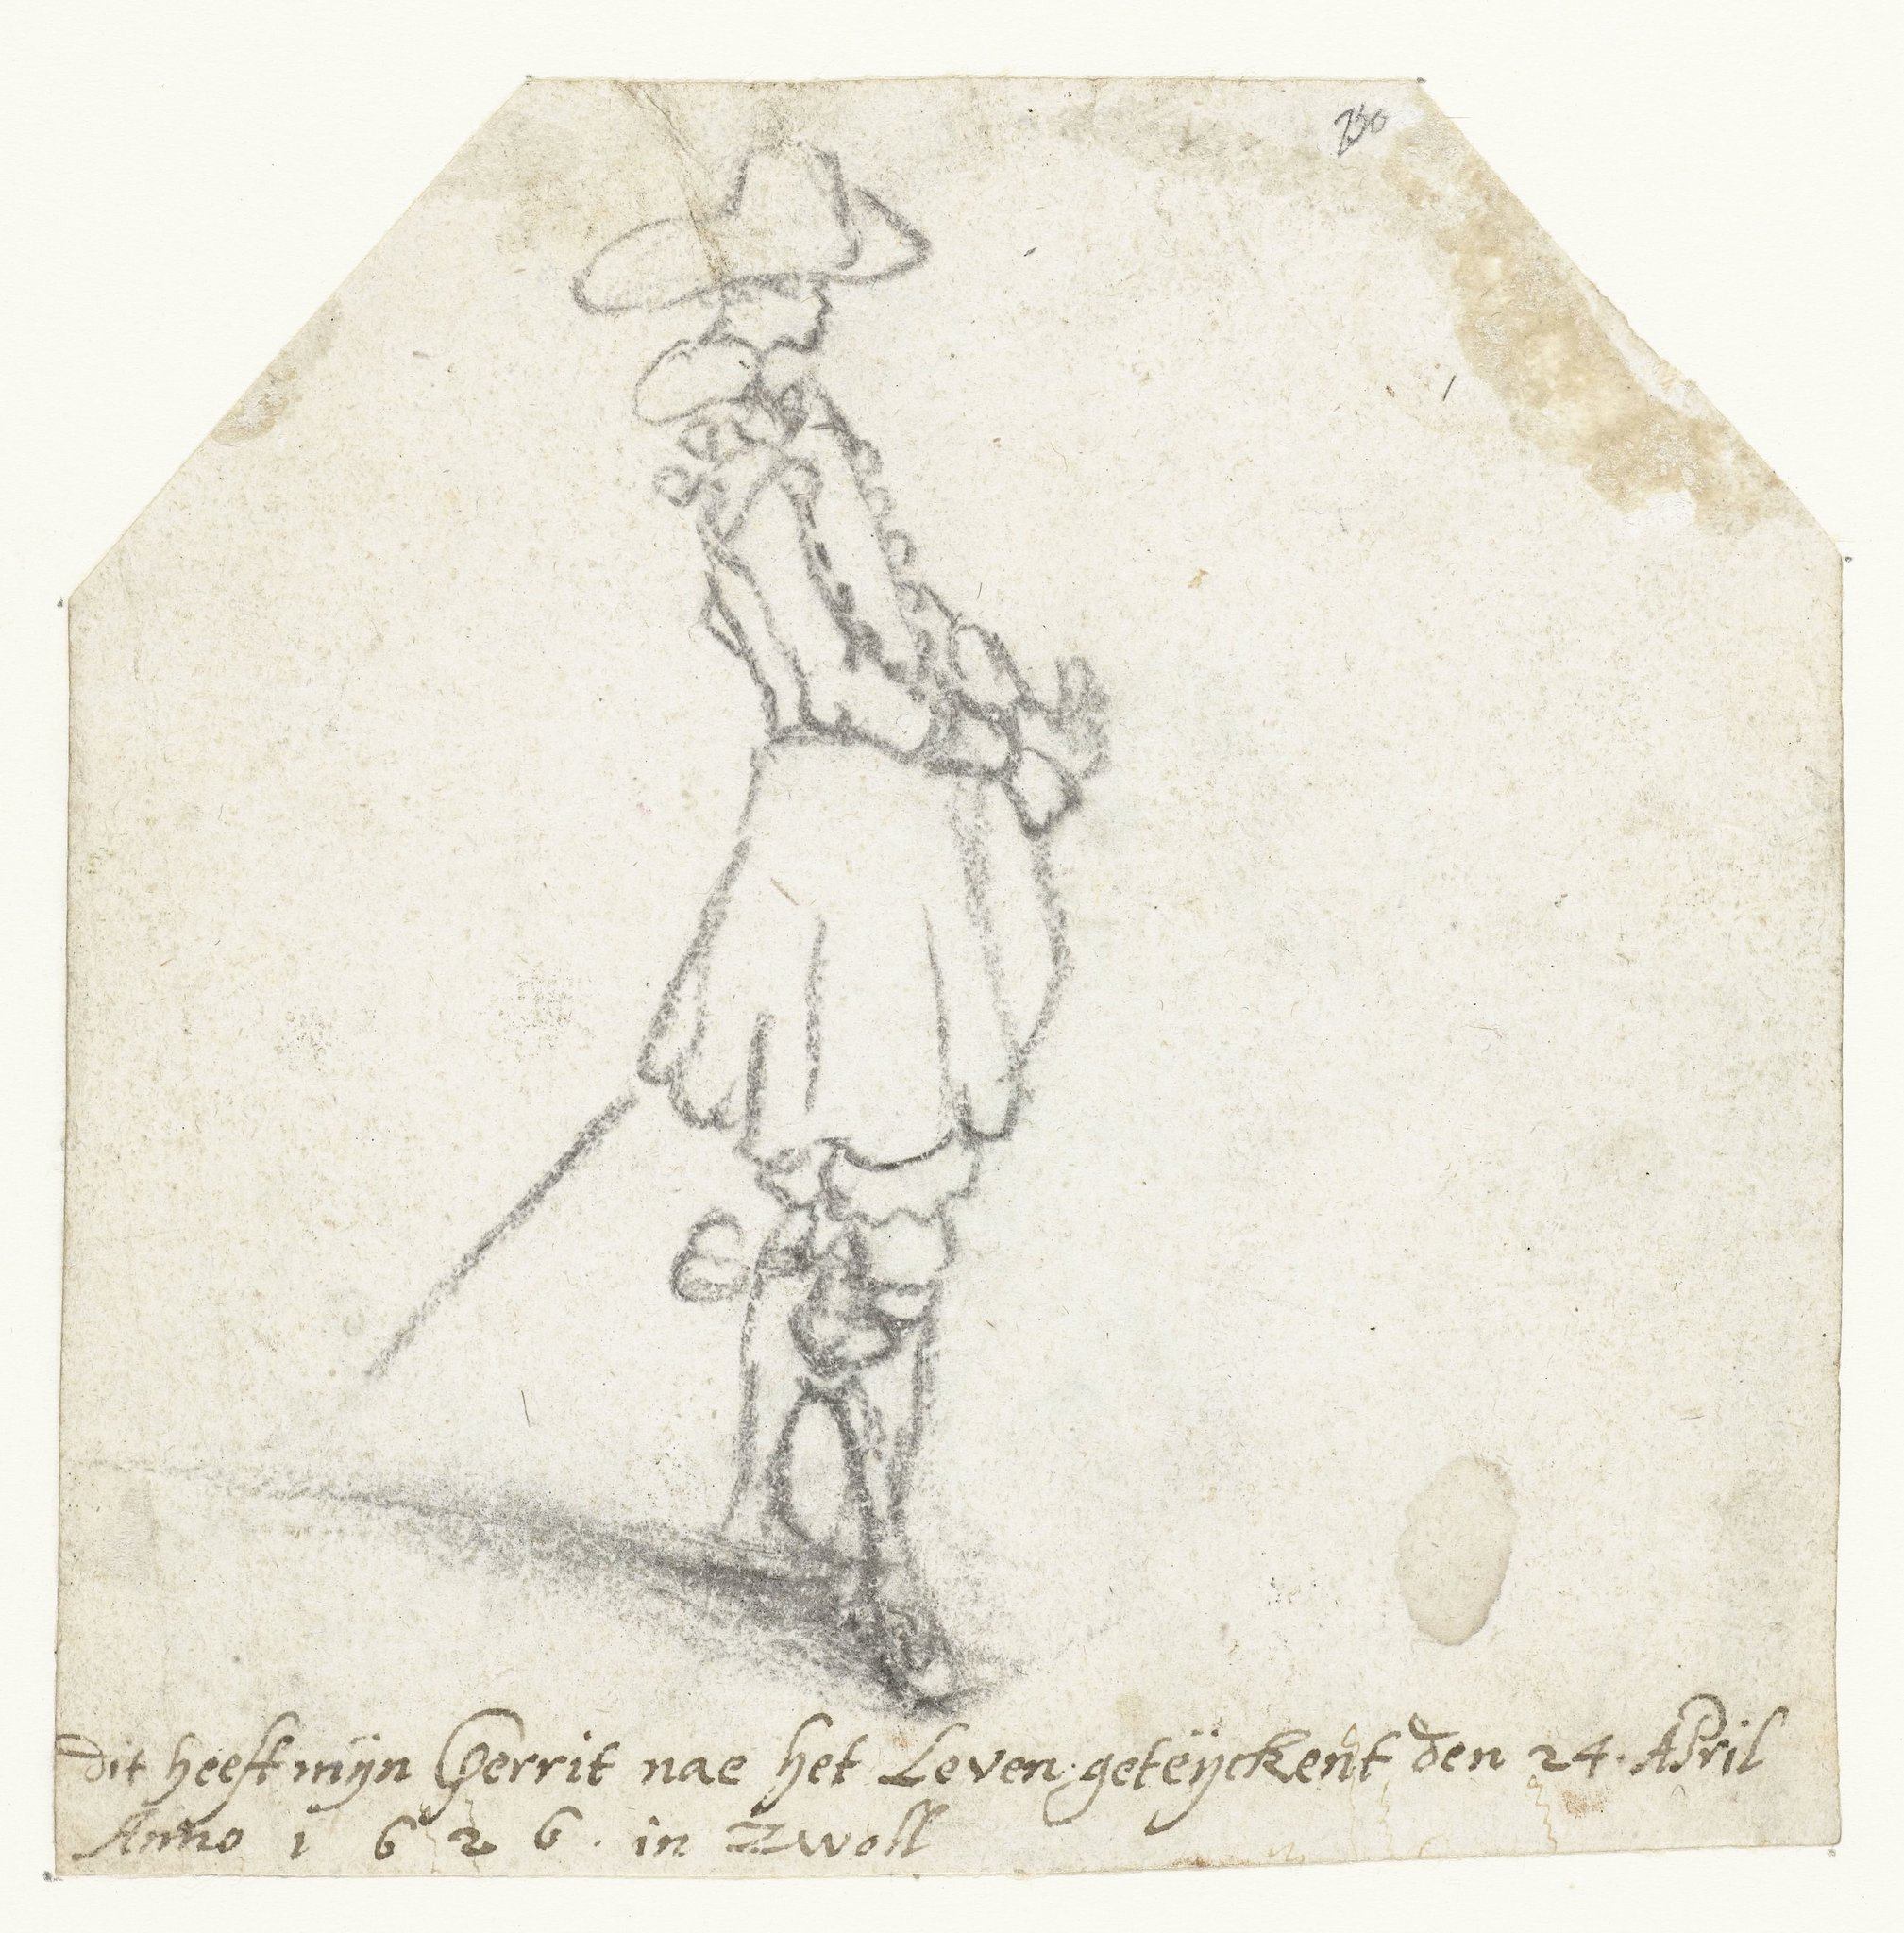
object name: drawing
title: Staande officier, in profiel naar rechts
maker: gerard ter borch (ii)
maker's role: draughtsman, painter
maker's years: 1617-1681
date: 1626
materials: chalk, paper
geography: zwolle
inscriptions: annotation: ‘dit heeft mijn Gerrit nae het leven geteijckent den 24.April / Anno 1626. in Zwoll’